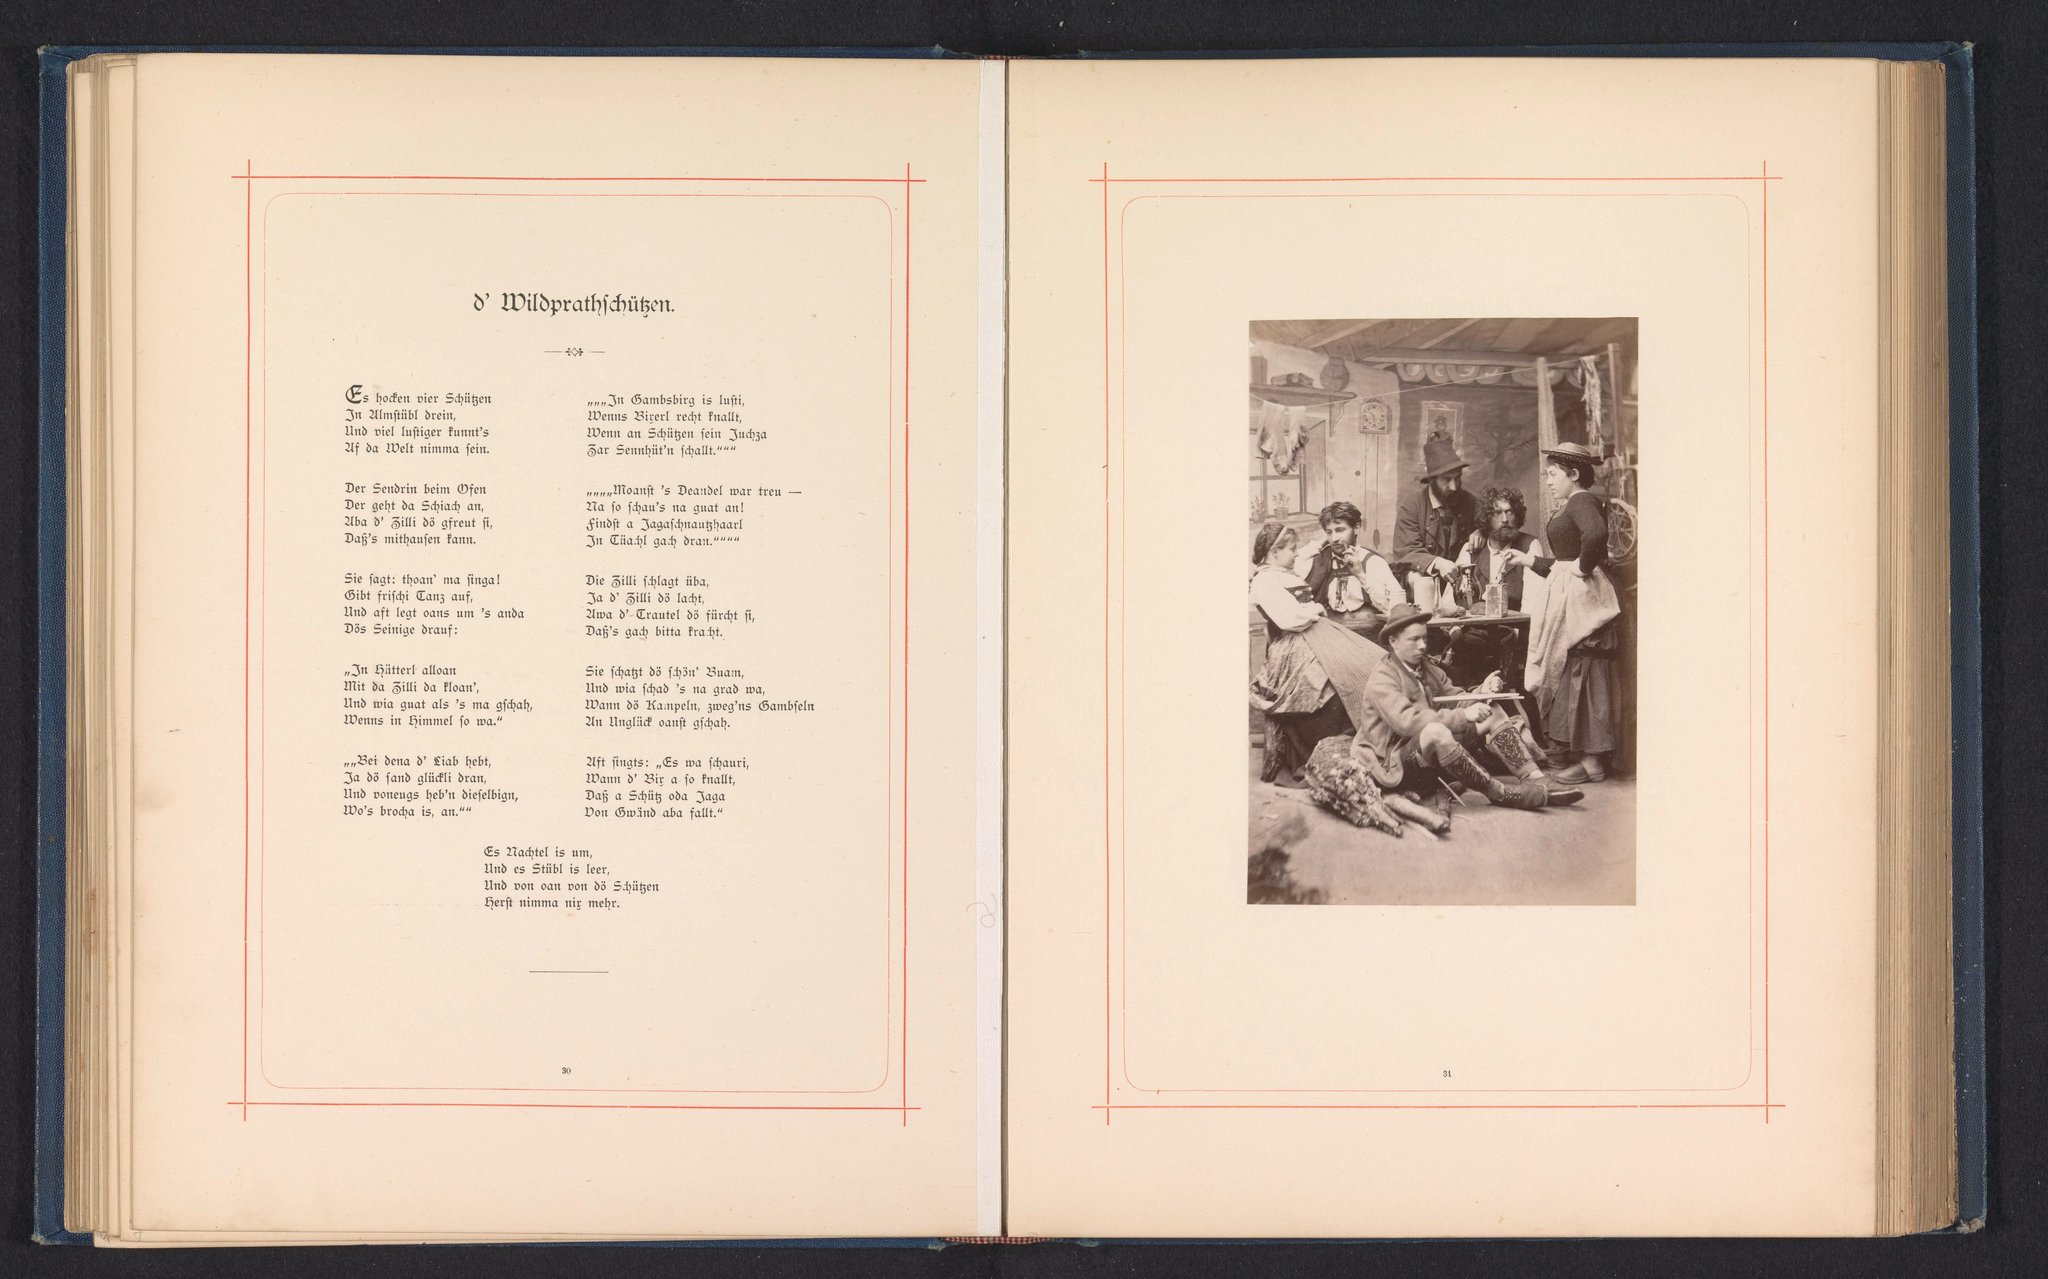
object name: page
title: Gezelschap in klederdracht rond een tafel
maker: max balde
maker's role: fotograaf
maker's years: 1844-1900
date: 1877-1882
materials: photographic support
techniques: albumen print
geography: salzburg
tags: adult woman, adult man, table, folk costume, regional costume